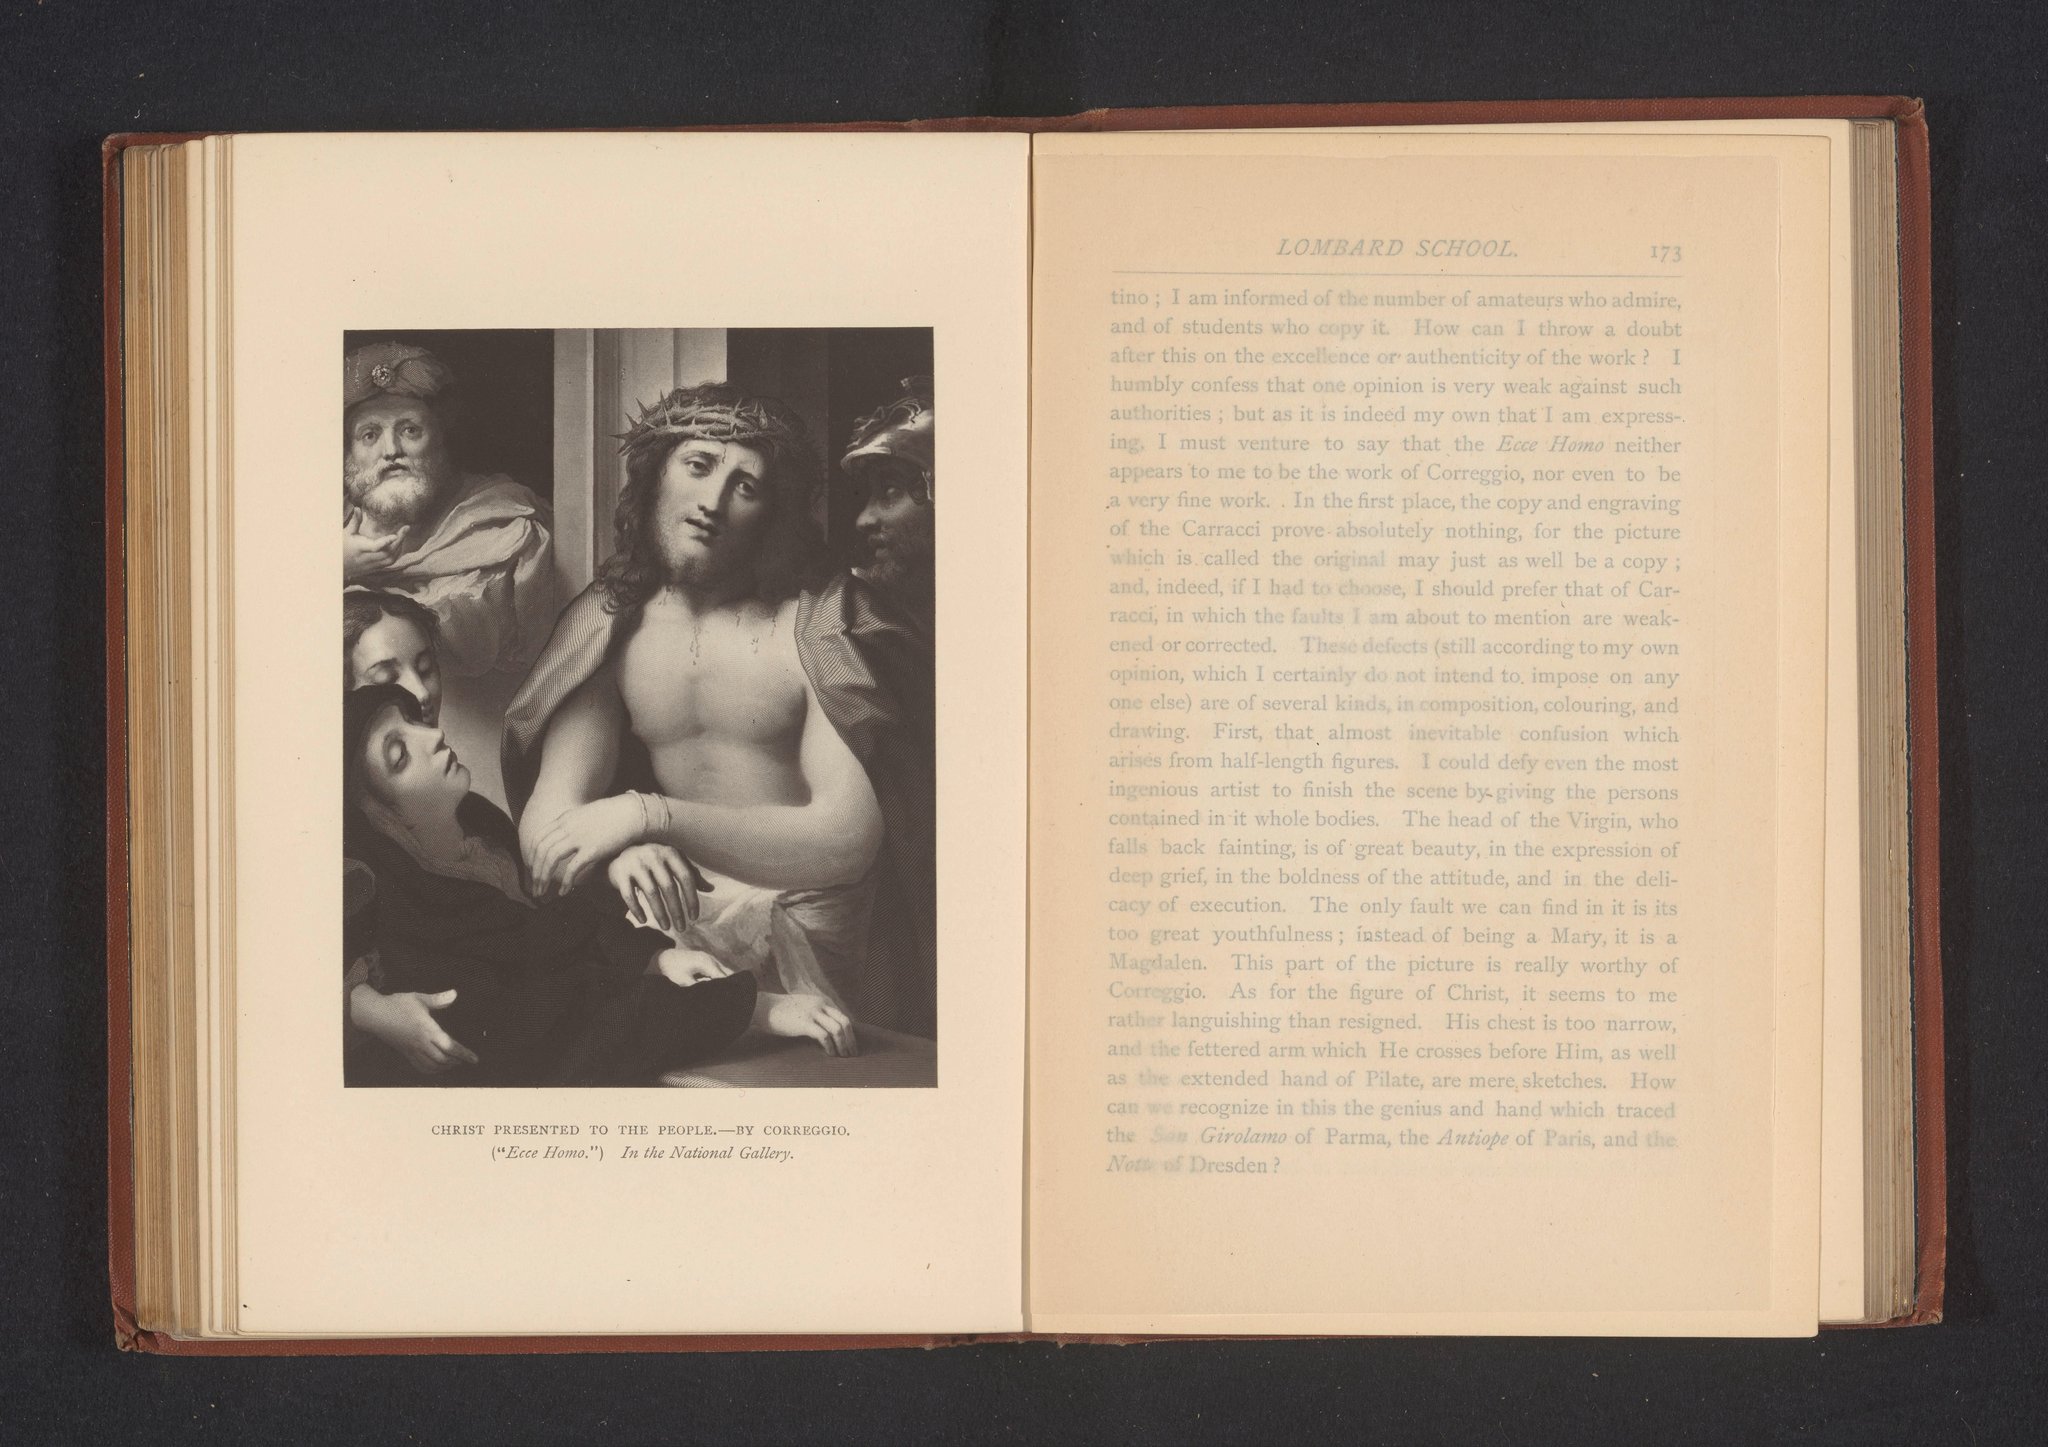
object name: photograph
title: Fotoreproductie van een prent naar het schilderij Ecce Homo door Correggio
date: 1860-1870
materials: photographic support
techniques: carbon print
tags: christ alone (also called 'ecce homo')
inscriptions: inscription: ‘In the National Gallery.’